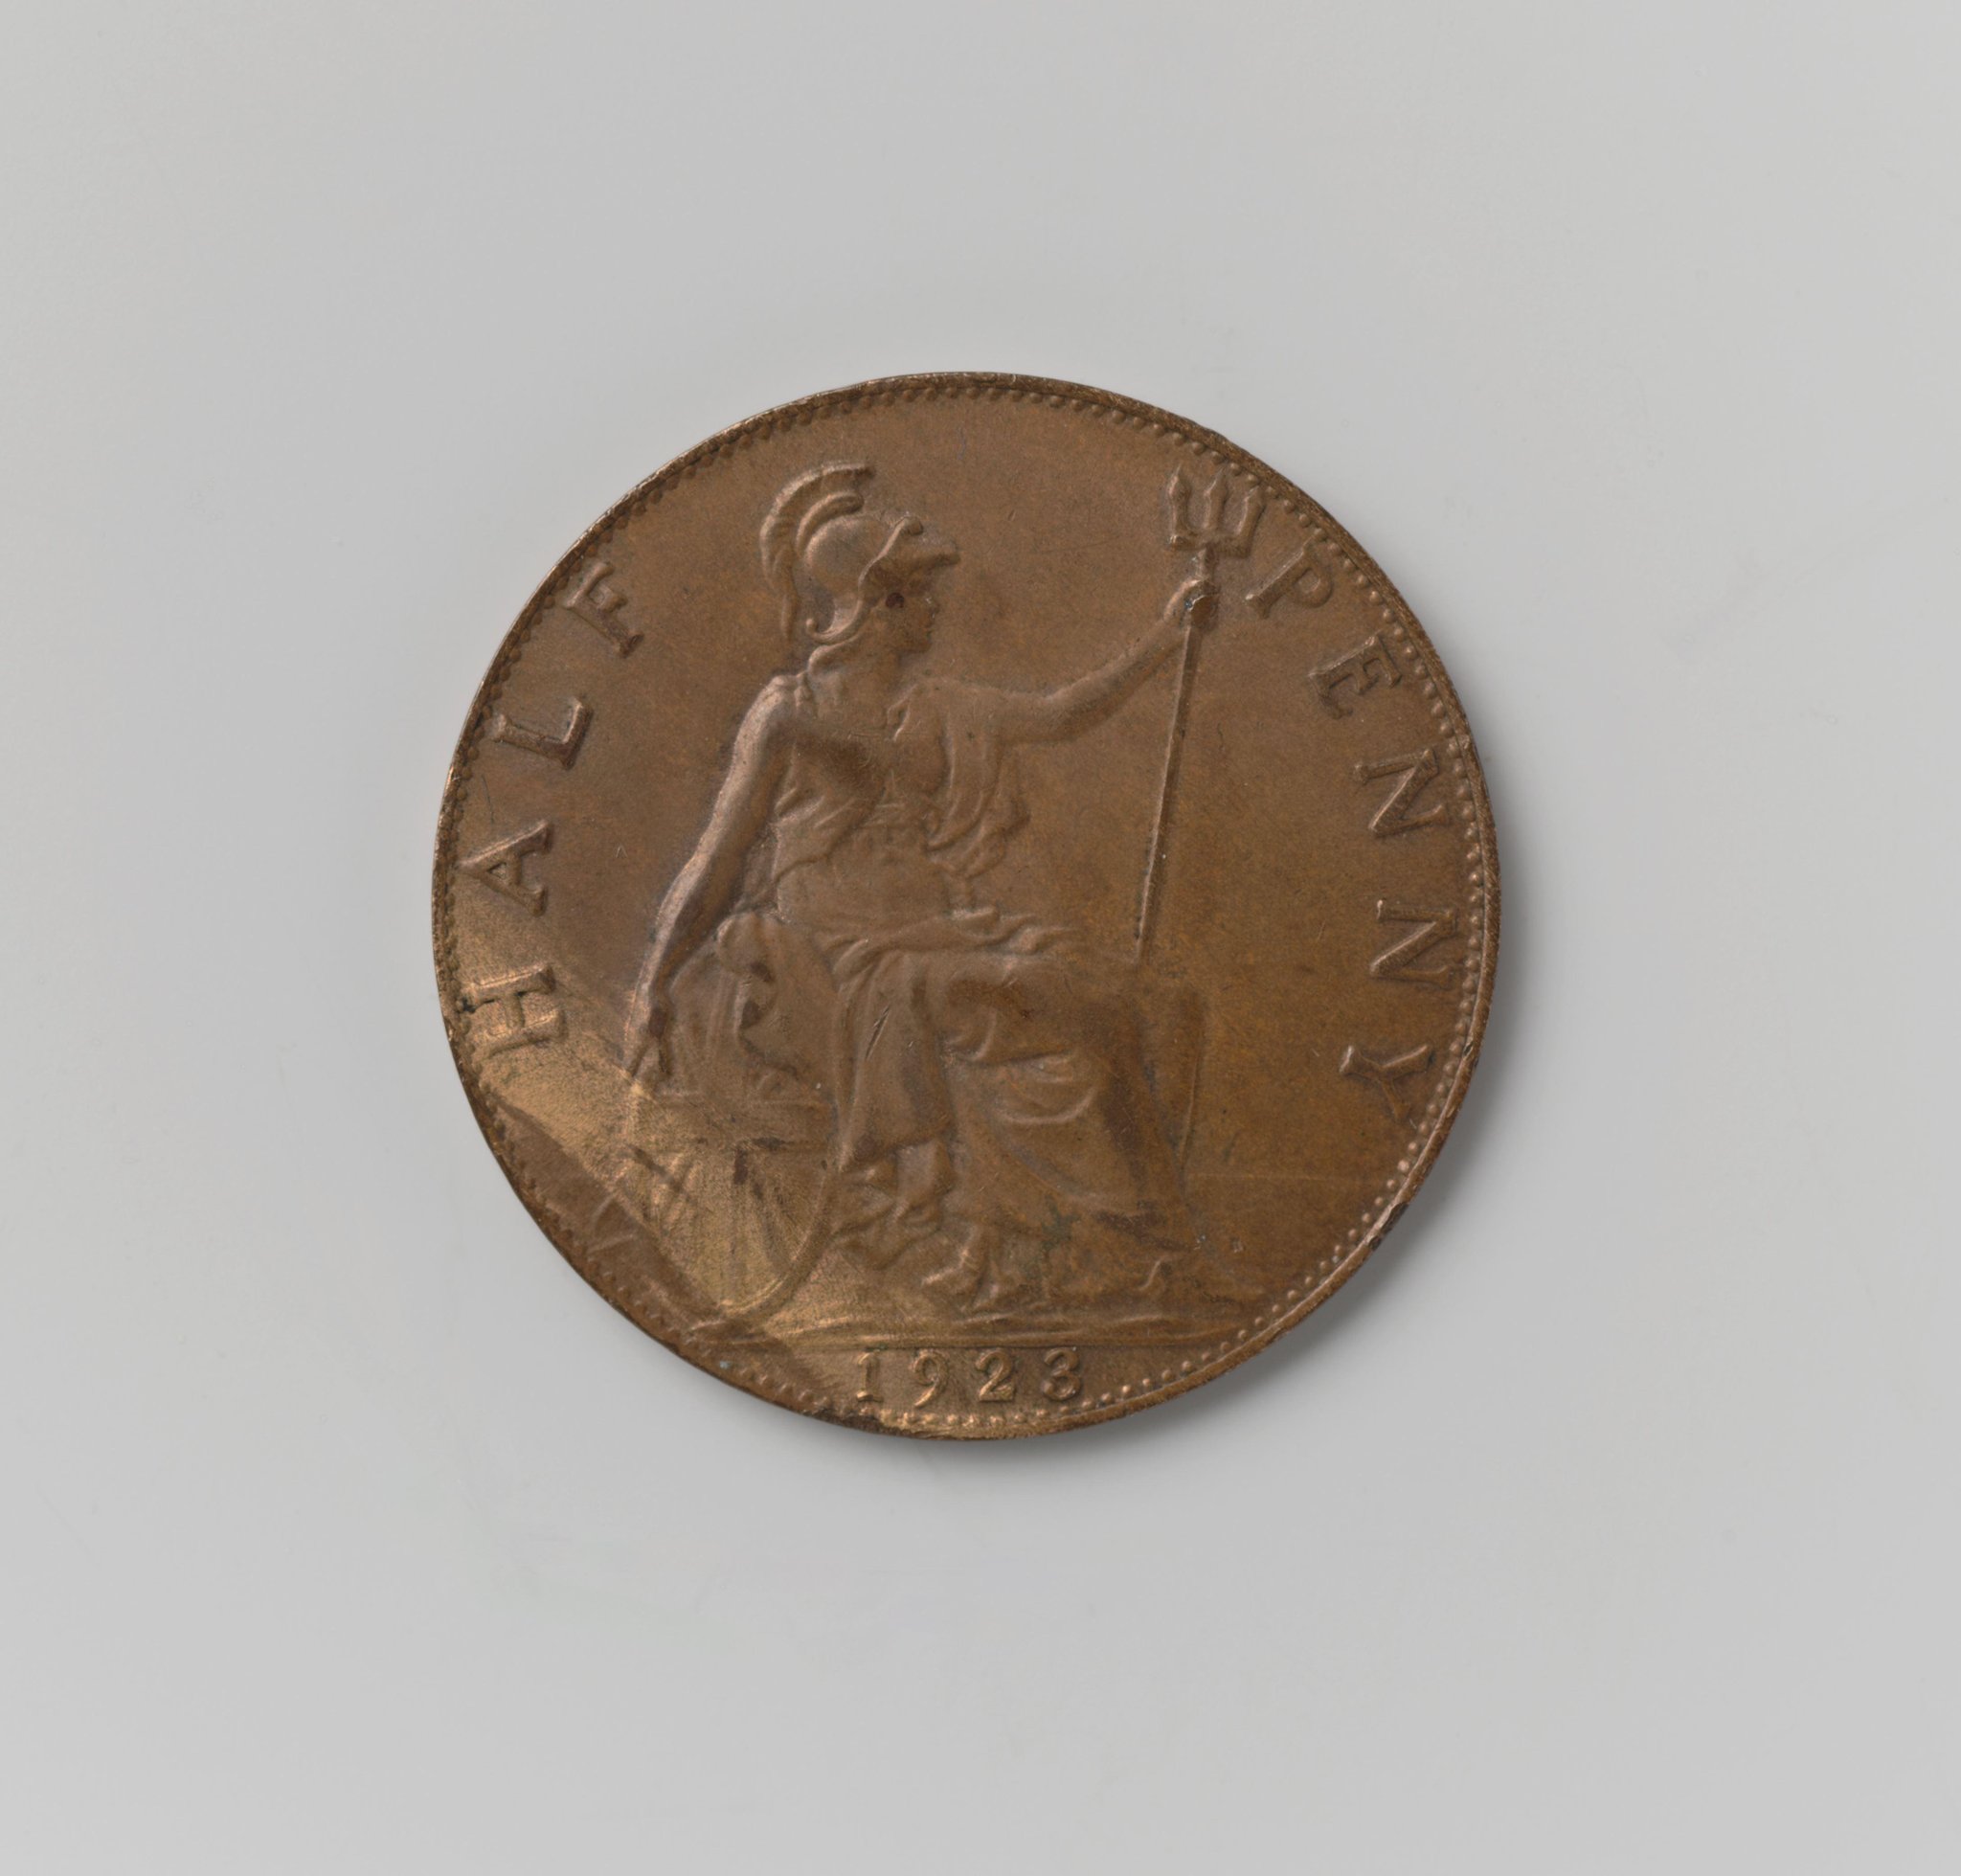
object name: halve penny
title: ½ penny uit Engeland van George V, 1923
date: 1923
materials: bronze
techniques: striking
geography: london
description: Bronzen munt. Voorzijde:gekroond borstbeeld van de koning naar links. Keerzijde: door zee omgeven, tegen wapenschild gezeten Brittannia met drietand, naar rechts. In afsnede jaartal. Waarde-aanduiding als omschrift. Gladde rand.